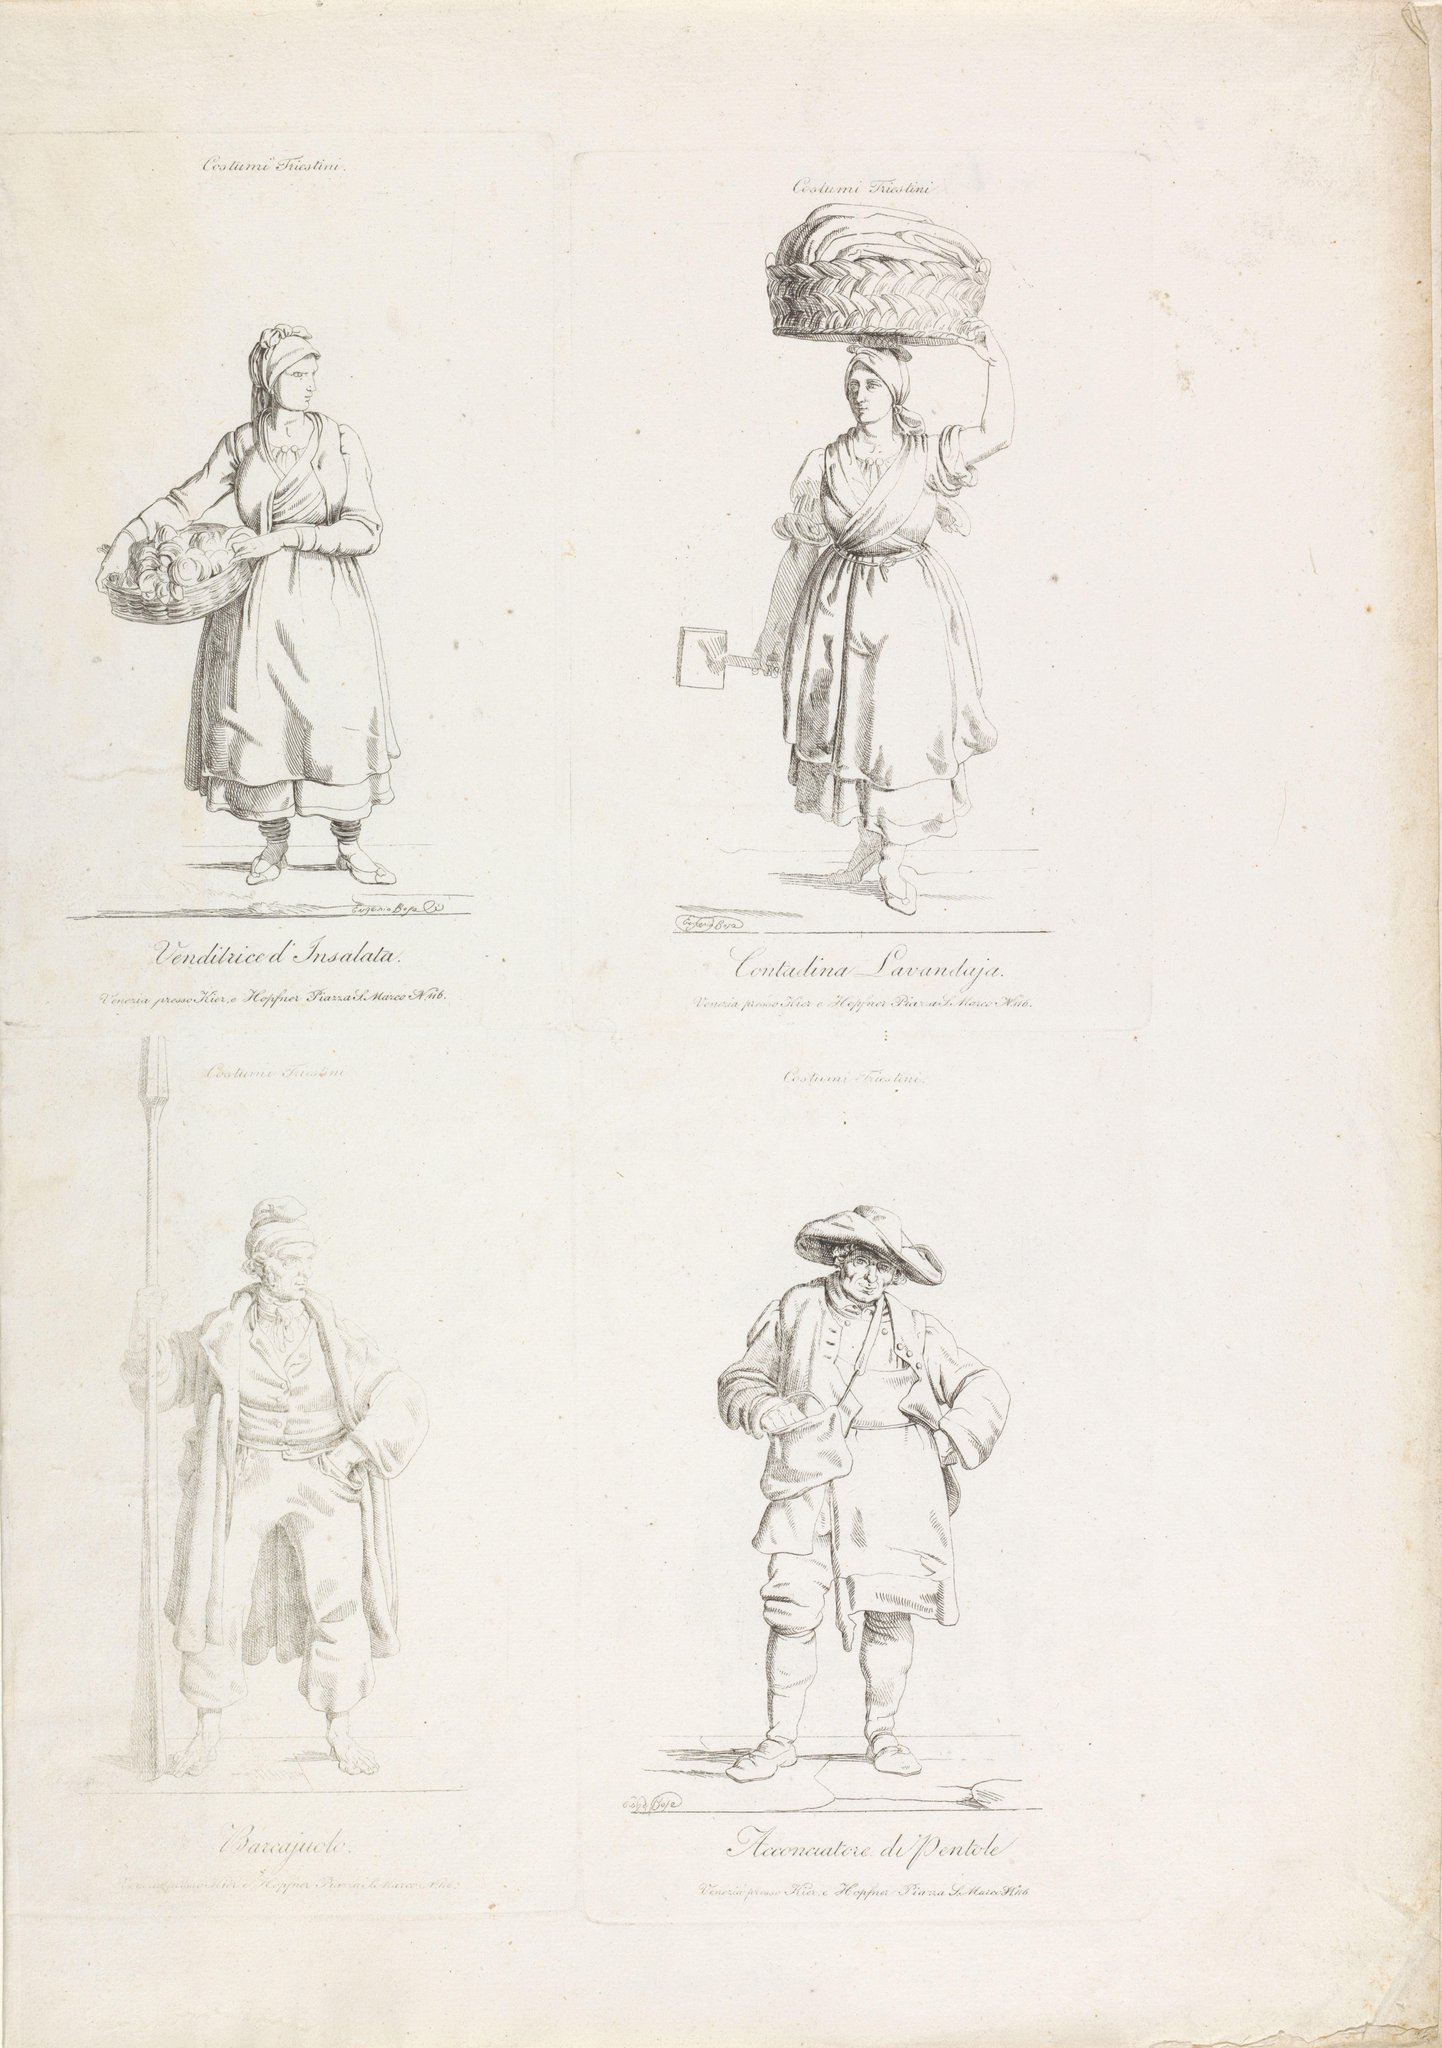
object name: print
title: Acht figuren uit Triëst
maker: eugenio bosa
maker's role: print maker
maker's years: 1807-1875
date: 1817-1875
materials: paper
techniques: etching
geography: italy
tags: human types, folk costume, regional costume, clothes, costume, merchant, salesman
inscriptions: collector's mark: Lugt 2228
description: Blad met acht voorstellingen. Een bloemenverkoopster, een boerenbruid, en slaverkoopster, een wasvrouw, een haringverkoopster, een boer in militair kostuum, een veerman en een kapper.